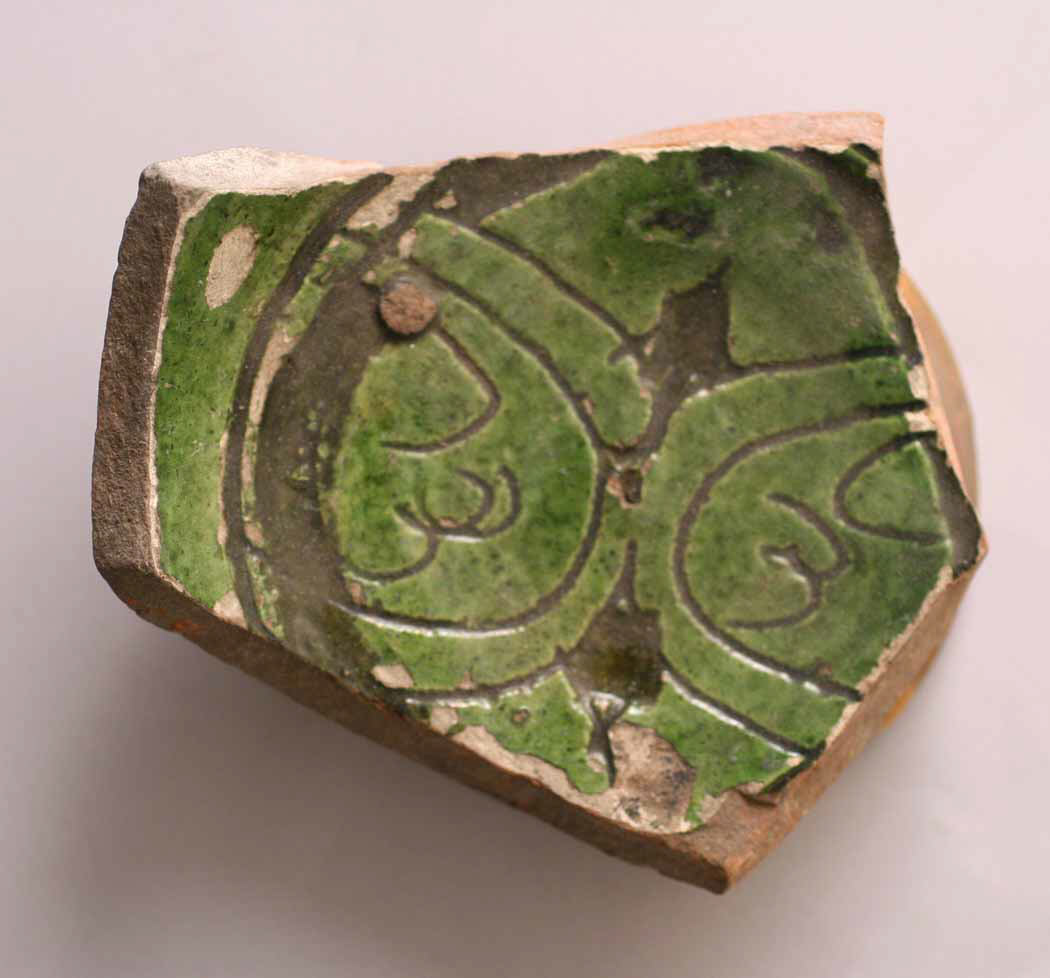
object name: ceramic fragment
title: Fragment of a Dish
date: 1301-1500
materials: earthenware, glaze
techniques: coloring, incising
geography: egypt